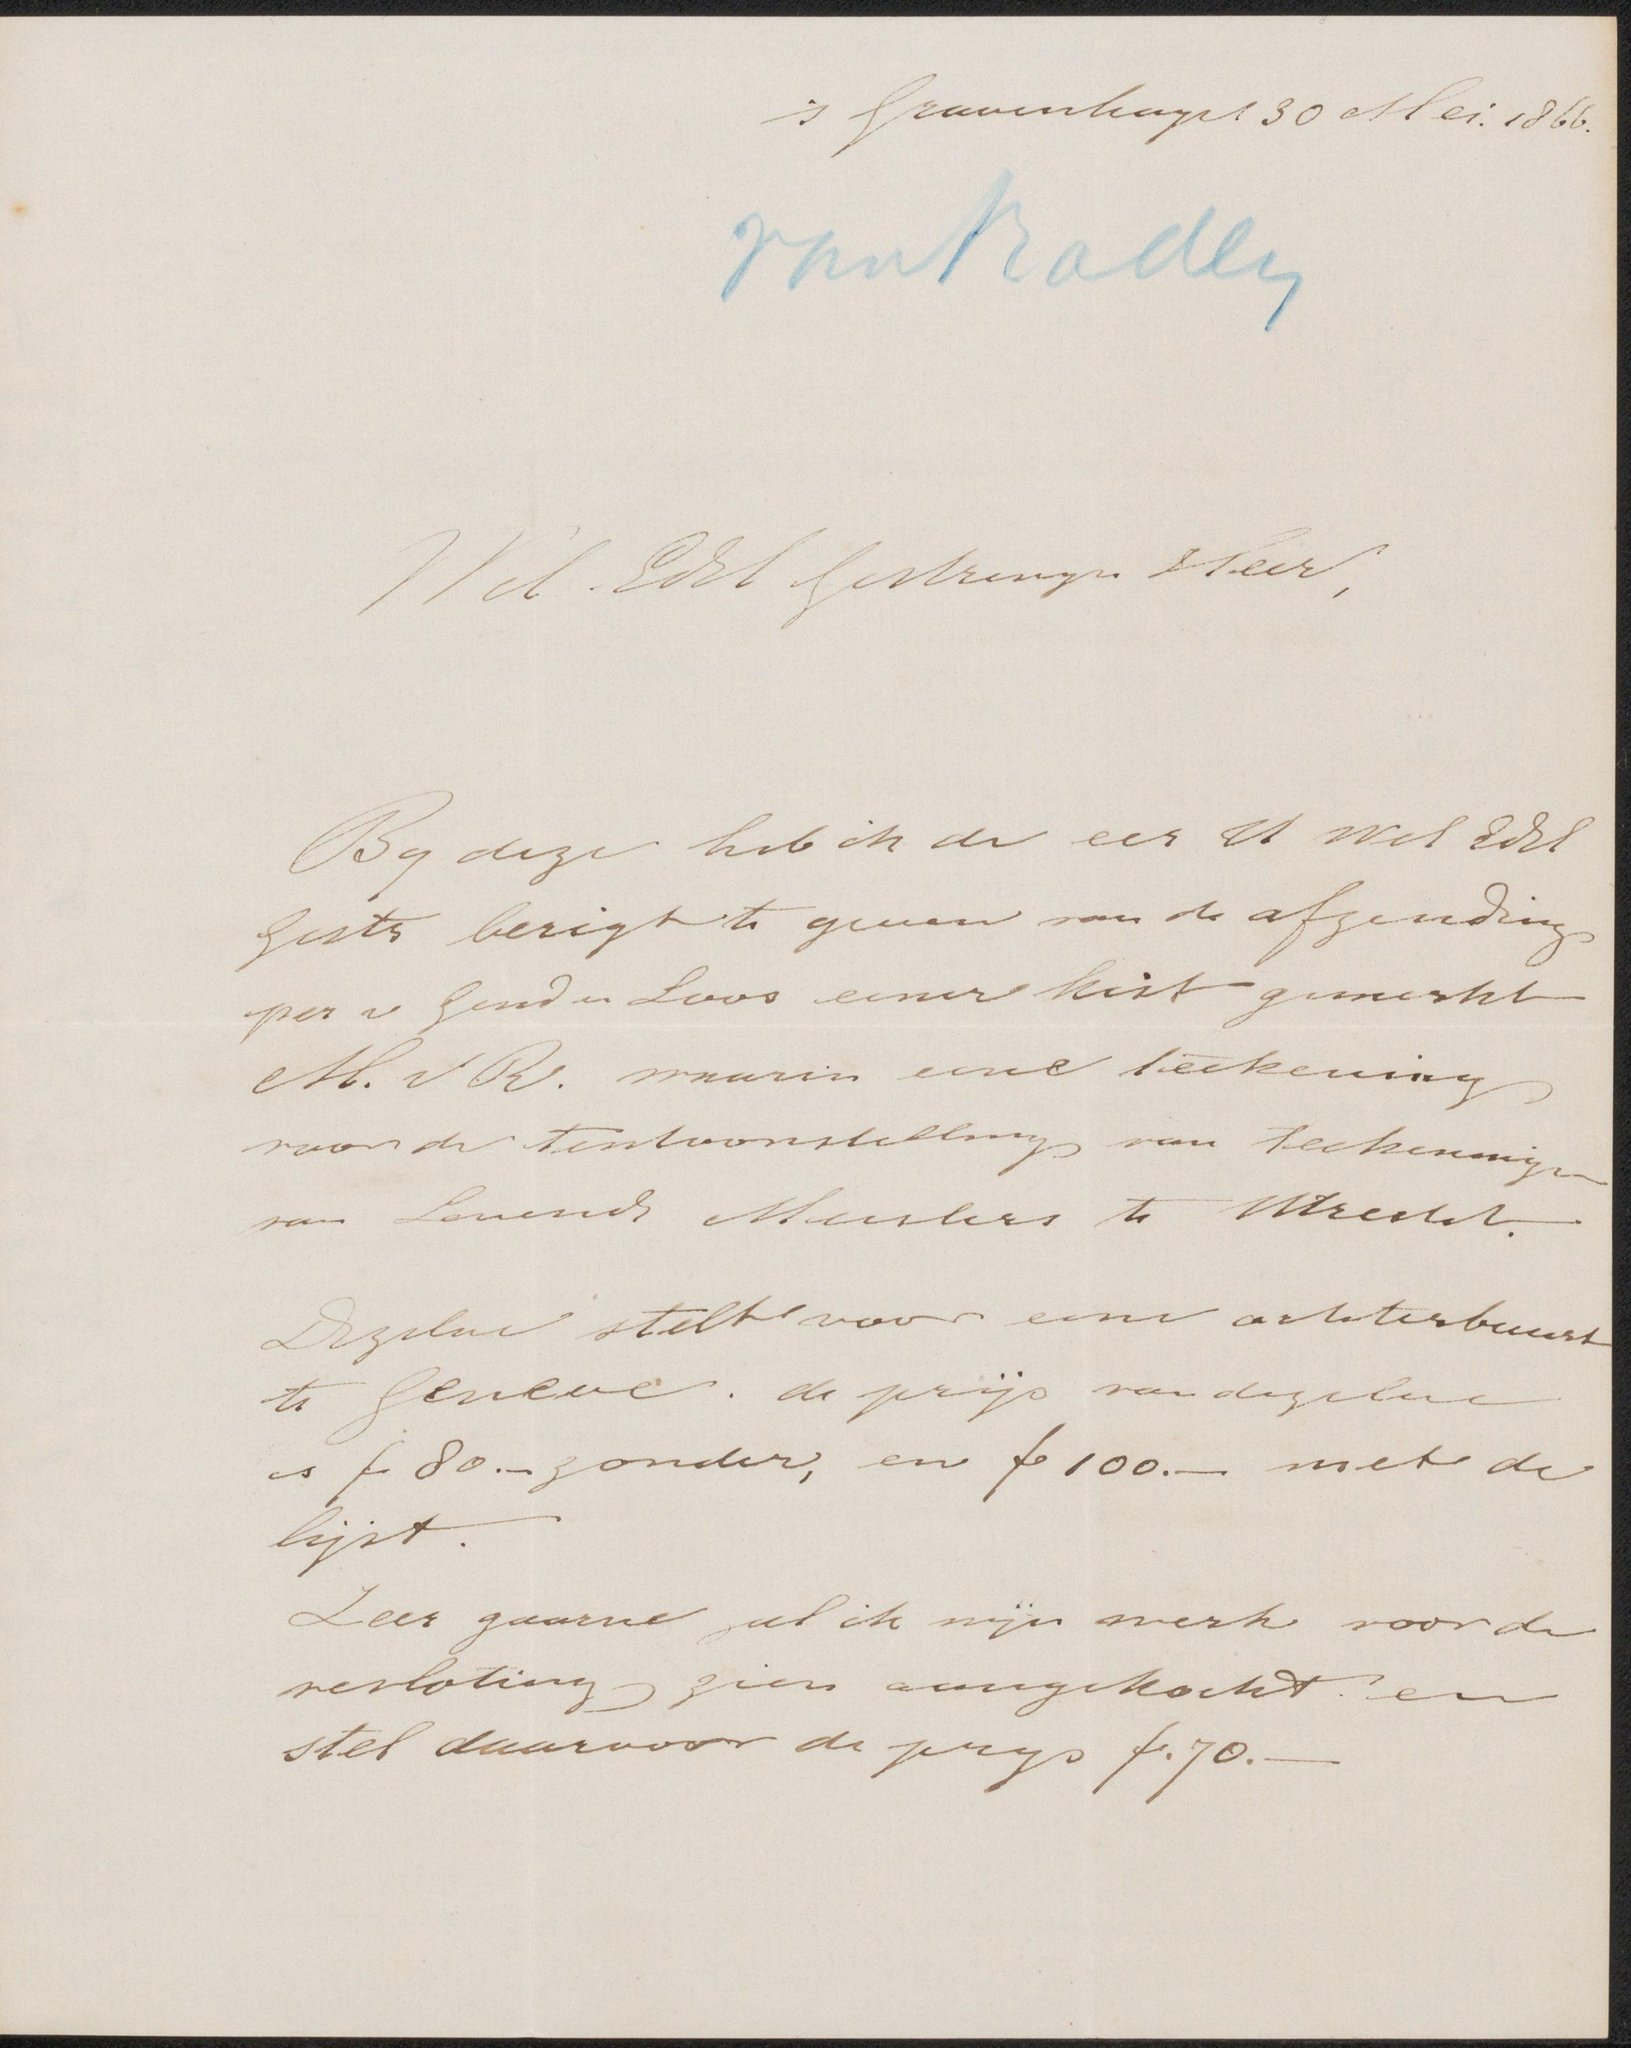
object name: letter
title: Brief aan Pieter Verloren van Themaat, secretaris van de Commissie van de Tentoonstelling van Levende Meesters in Utrecht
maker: marinus van raden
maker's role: draughtsman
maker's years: 1832-1879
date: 1866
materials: ink, paper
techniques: pen, writing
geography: the hague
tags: utrecht, pieter verloren van themaat, drawing, exhibition ~ art, money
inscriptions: watermark